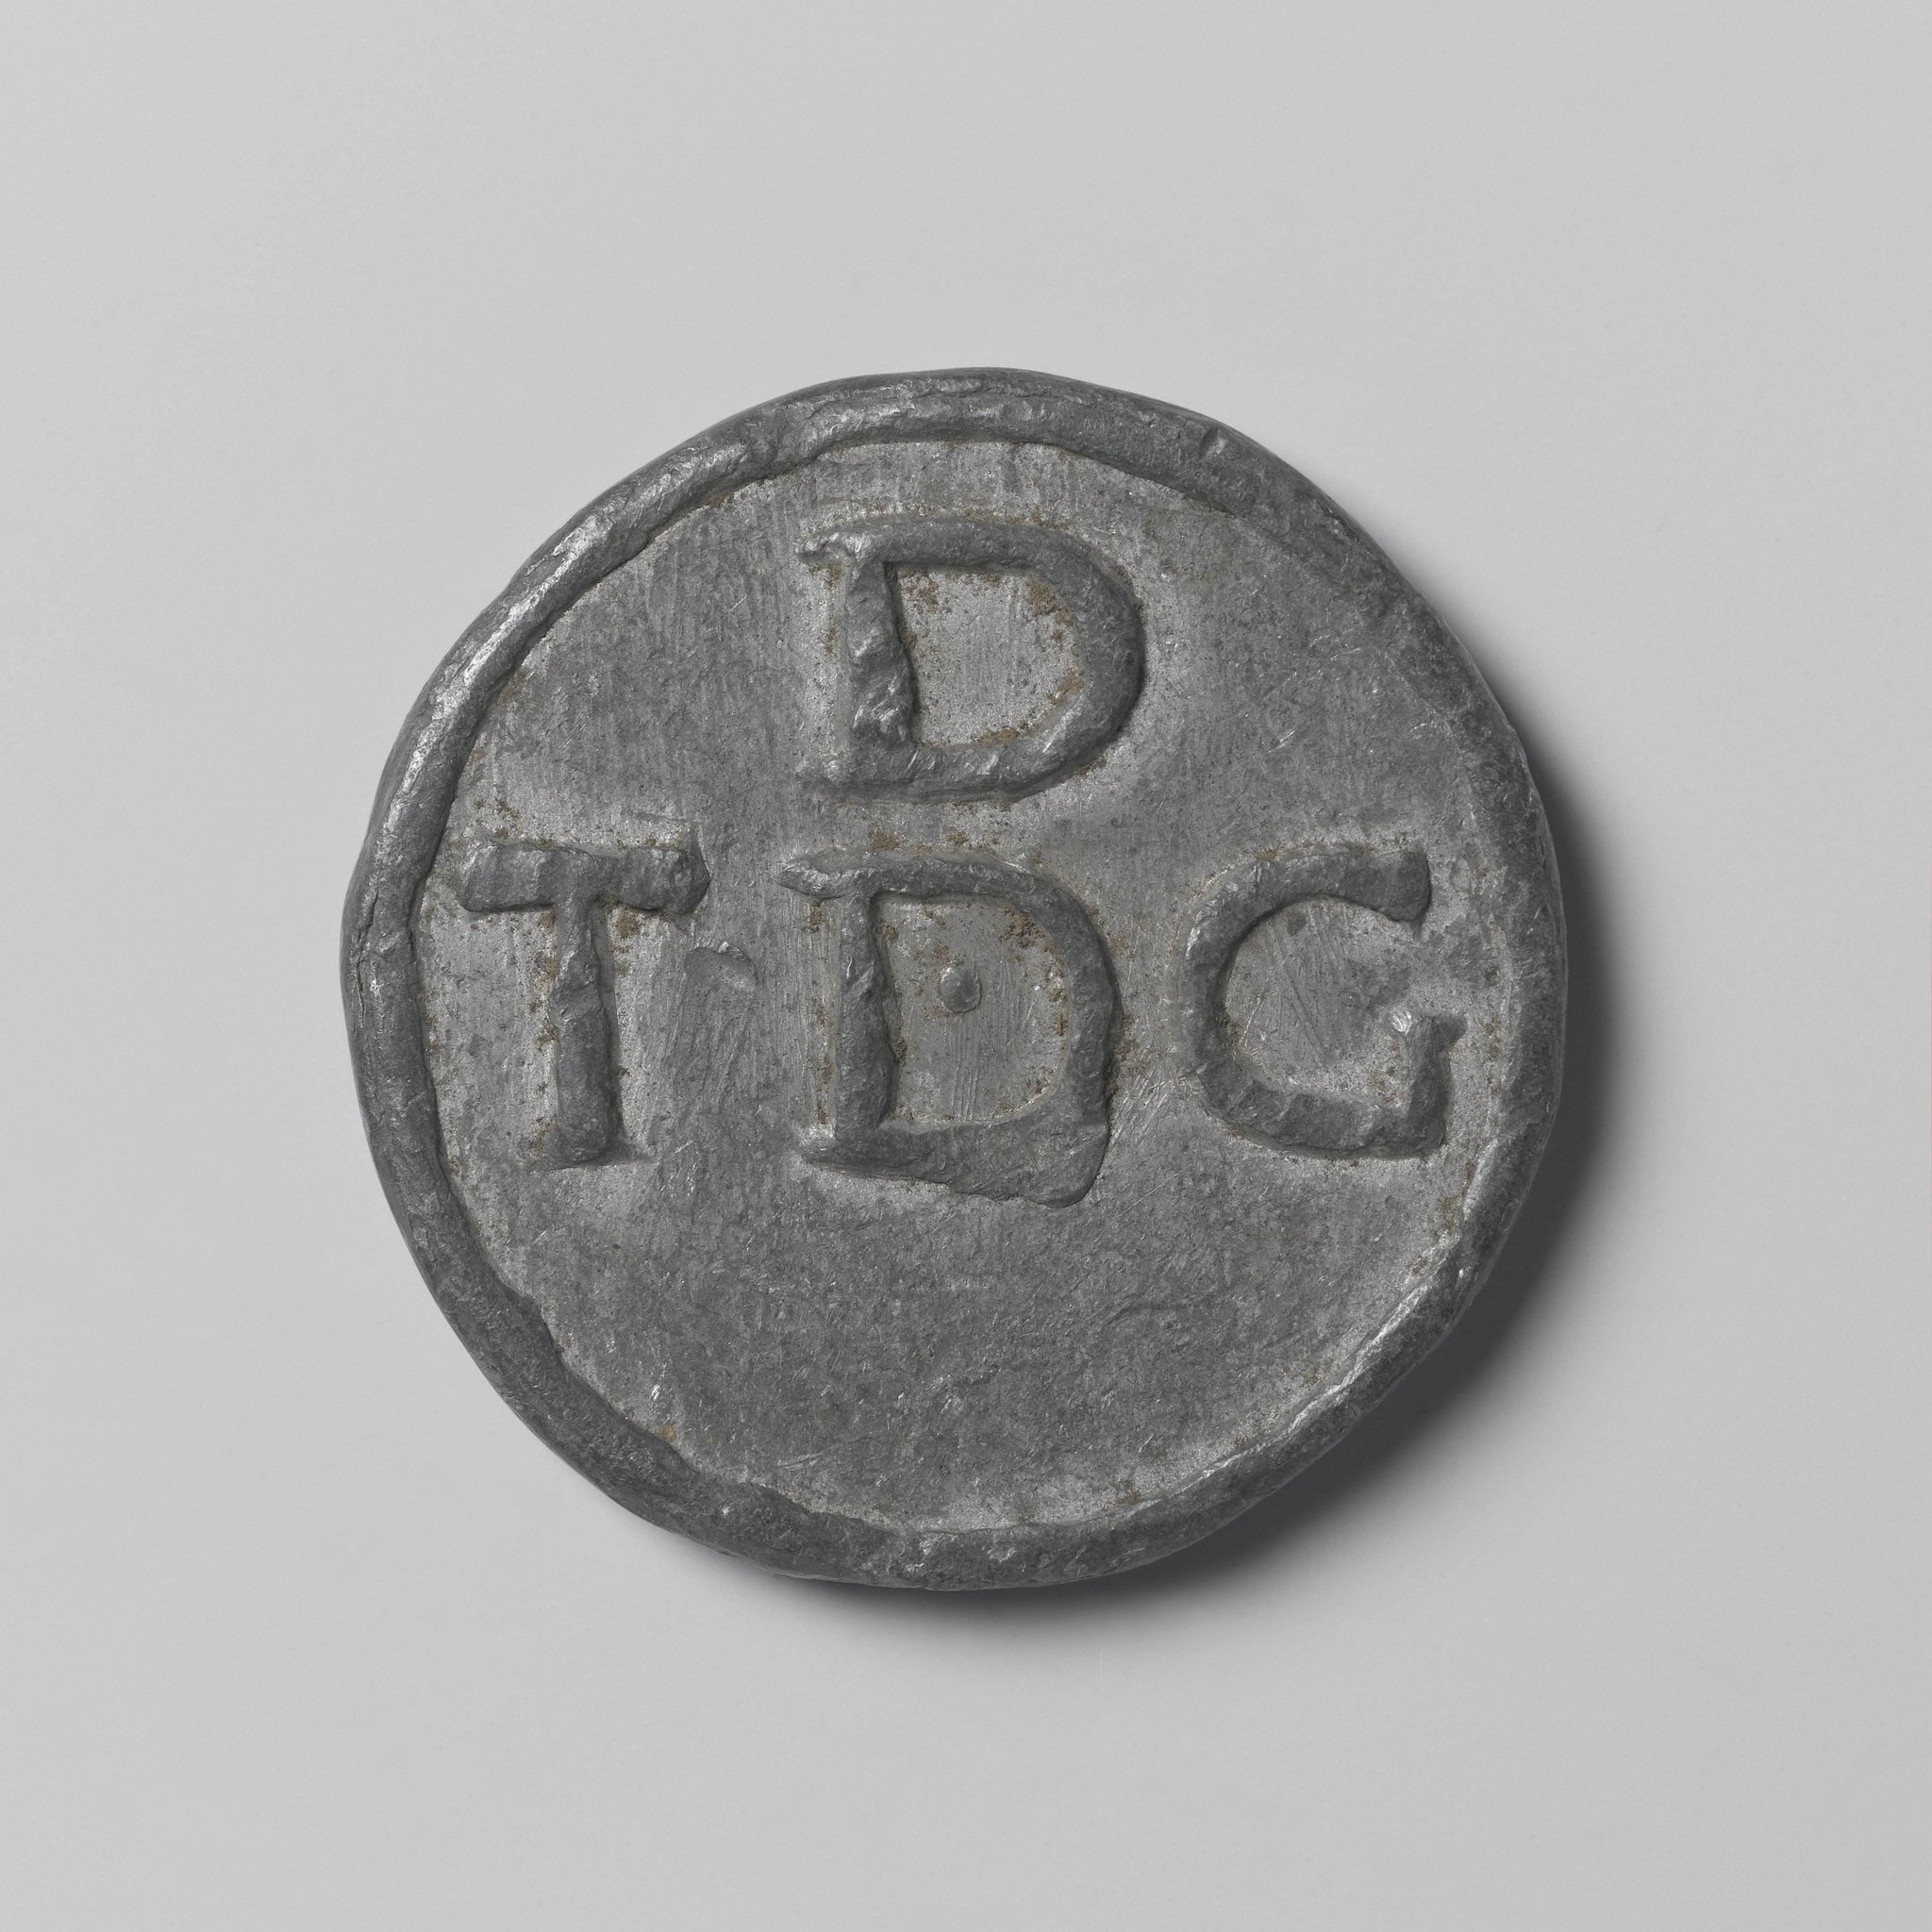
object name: presentiepenning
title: Turfdragersgilde van Amsterdam, presentiepenning met letter D en cijfer 92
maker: Anonymous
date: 1600-1800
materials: lead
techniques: casting, engraving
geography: amsterdam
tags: amsterdam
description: Loden penning. Voorzijde: cijfer 92. Keerzijde: letters T, D en G; onder D: letter D